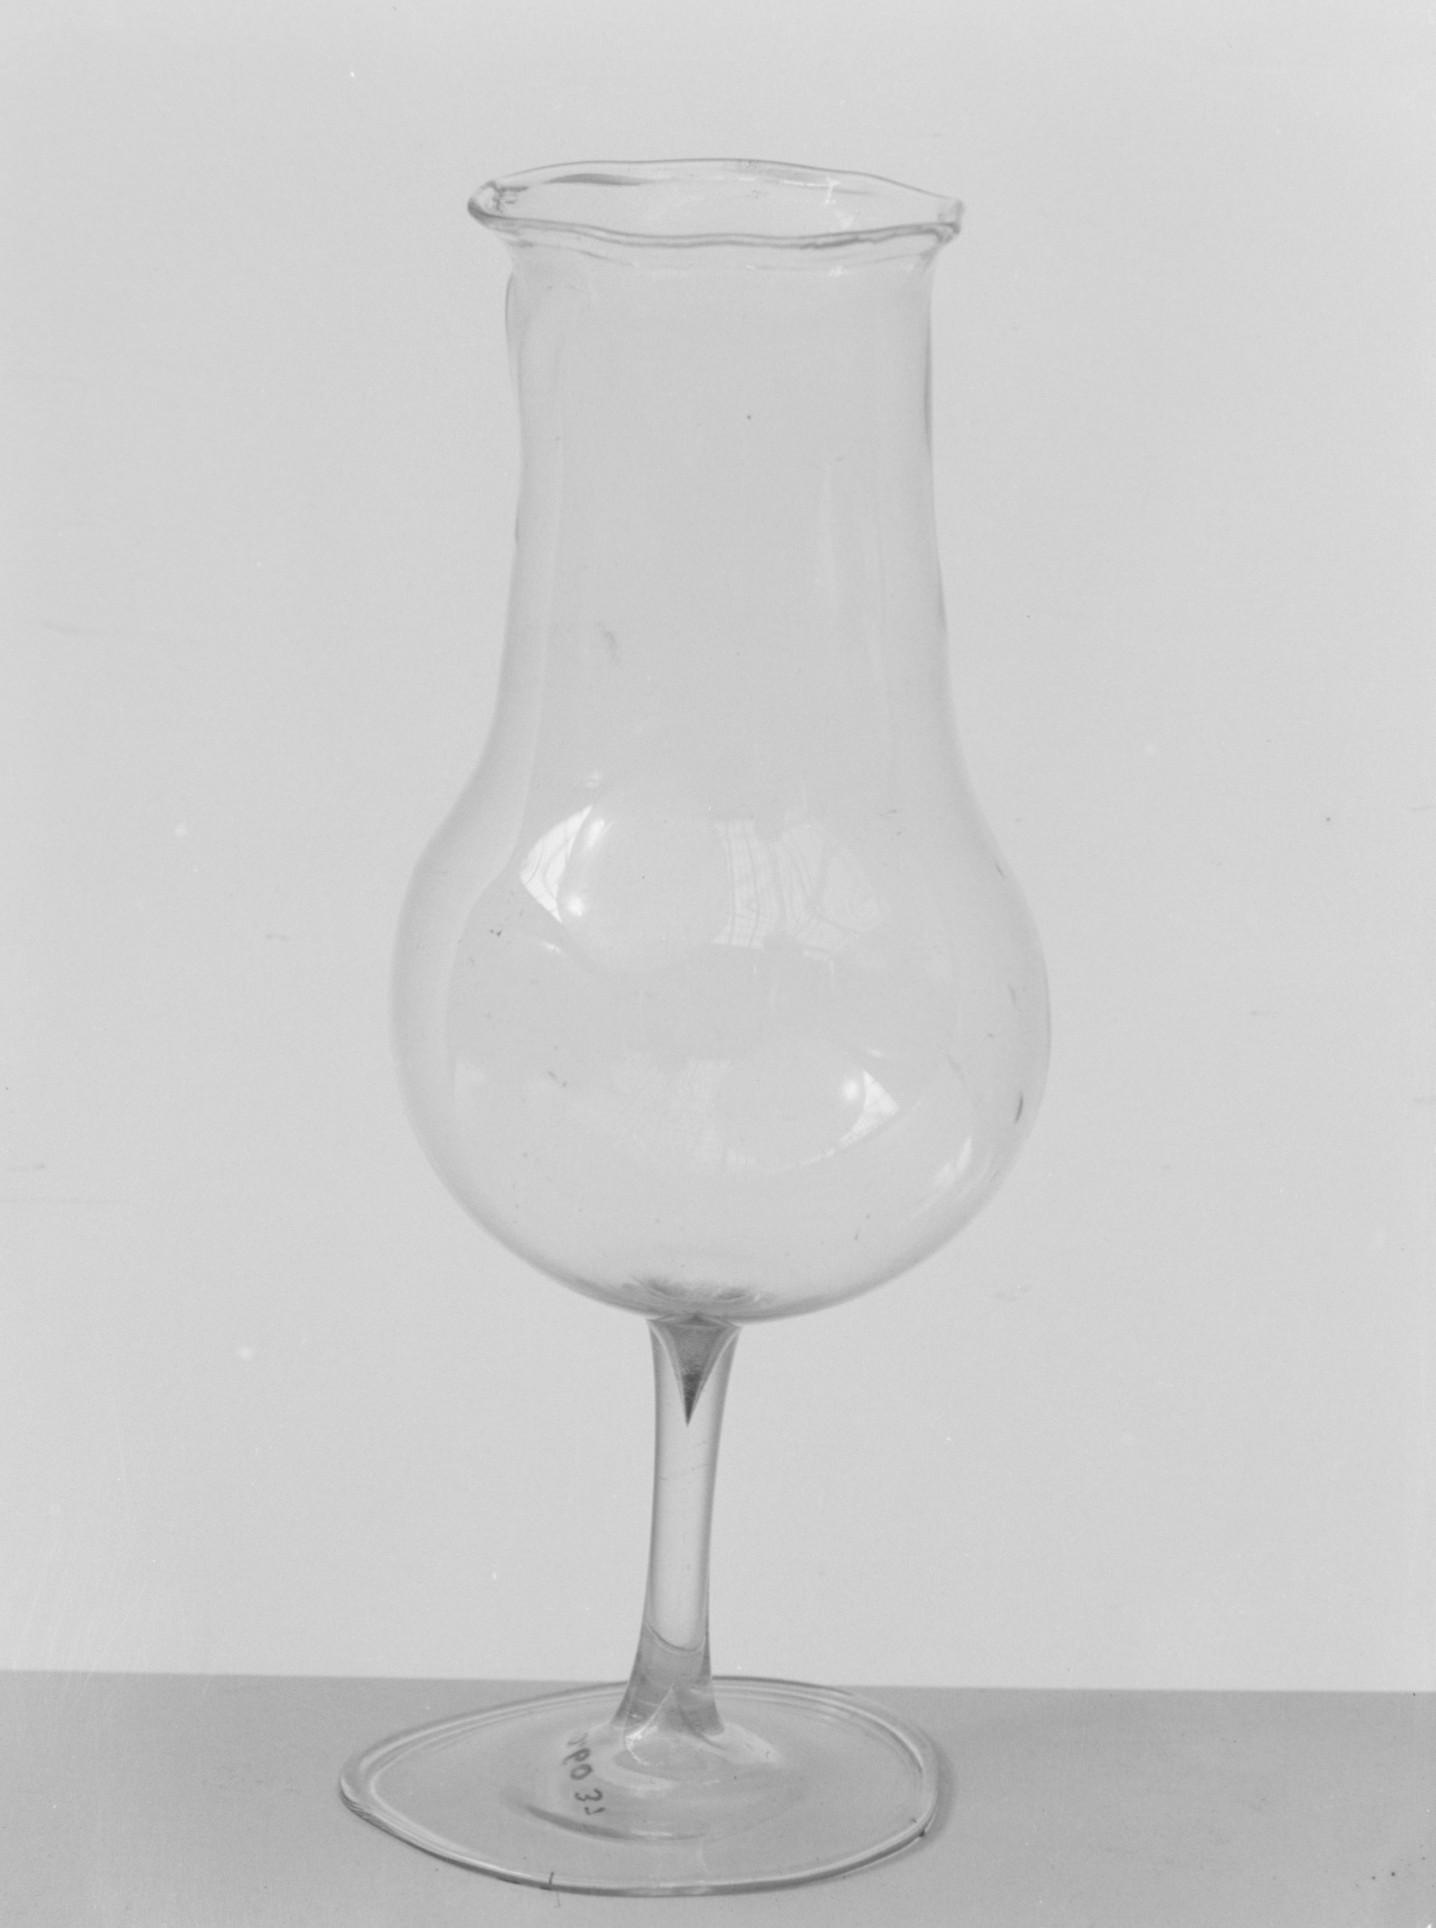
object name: wineglass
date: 1767-1833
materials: glass